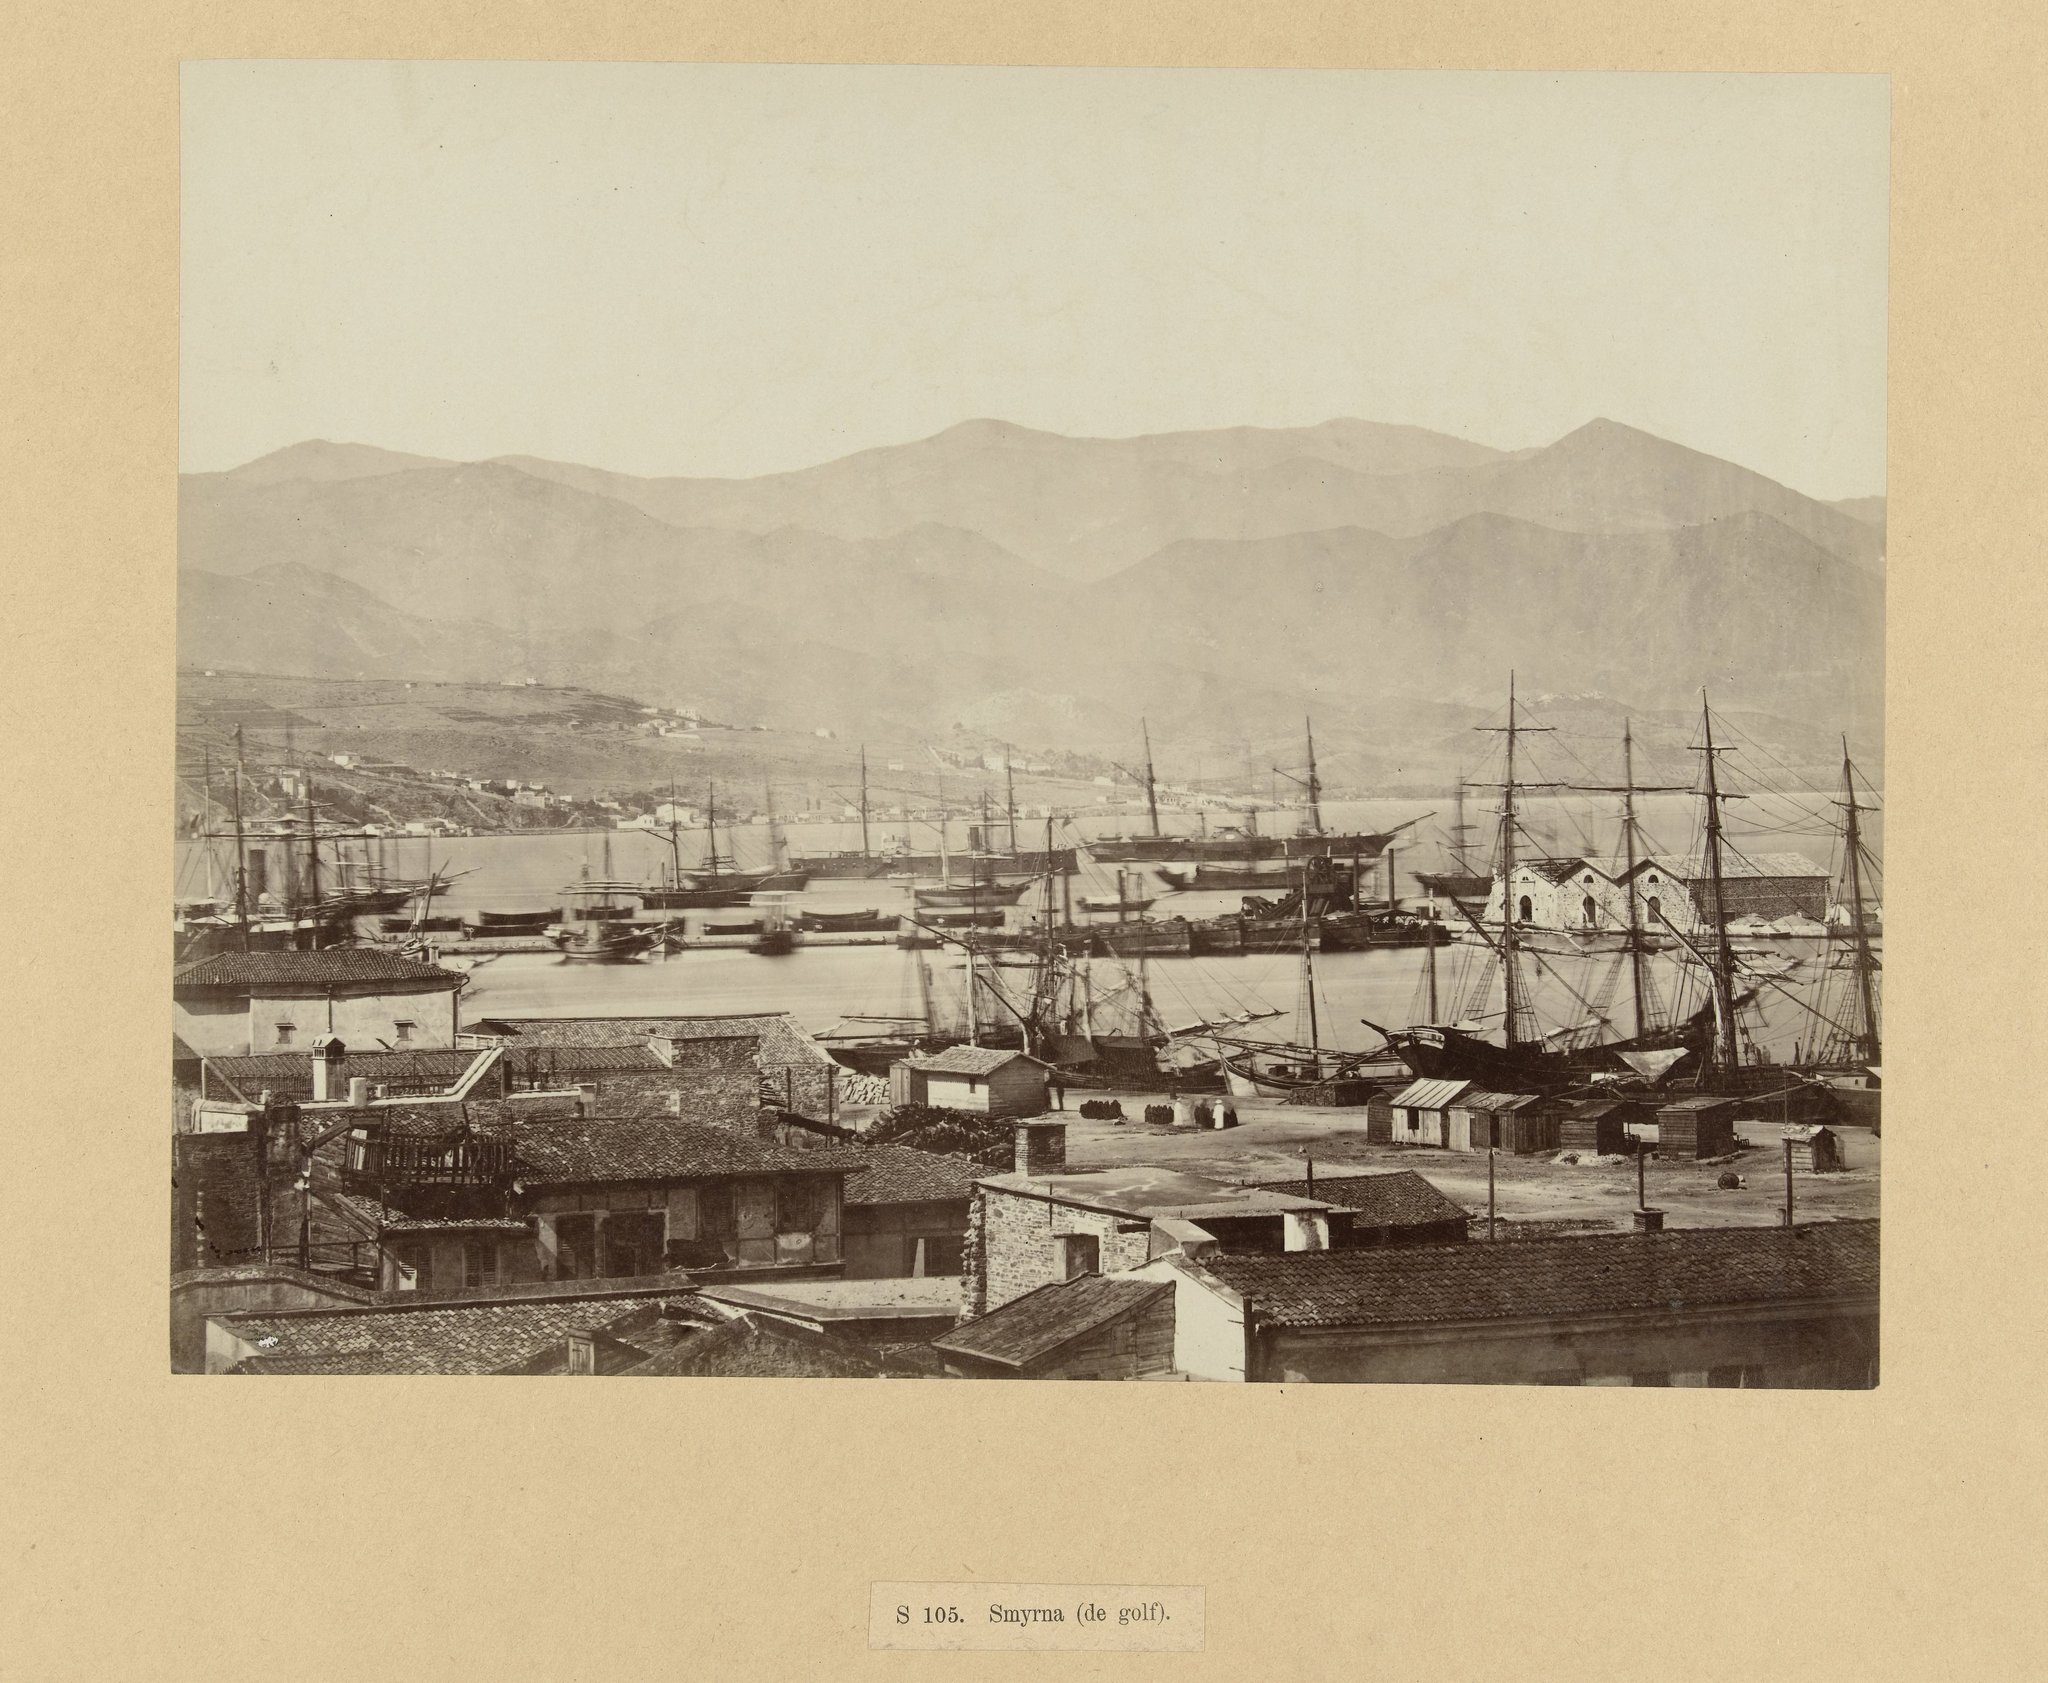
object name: photograph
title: Gezicht op de baai van Smyrna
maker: Anonymous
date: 1890-1895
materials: cardboard, paper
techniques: albumen print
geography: smyrna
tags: harbour, gulf, bay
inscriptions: stamp: ‘Gemeentelijke bibliotheek/ Rotterdam’, check stamp: ‘Bristol/ L.M.’, title: ‘S 105. Smyrna (de golf).’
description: Onderdeel van een groep door fotograaf Richard Polak op reis verzamelde foto’s. Deze foto is samen met andere op zijn reizen verzamelde foto's tentoongesteld bij de Rotterdamsche Kunstkring (1895), Arti en Amicitiae te Amsterdam (1897-1898?) en Societeit 't Collegie te Kampen (datum vooralsnog onbekend).